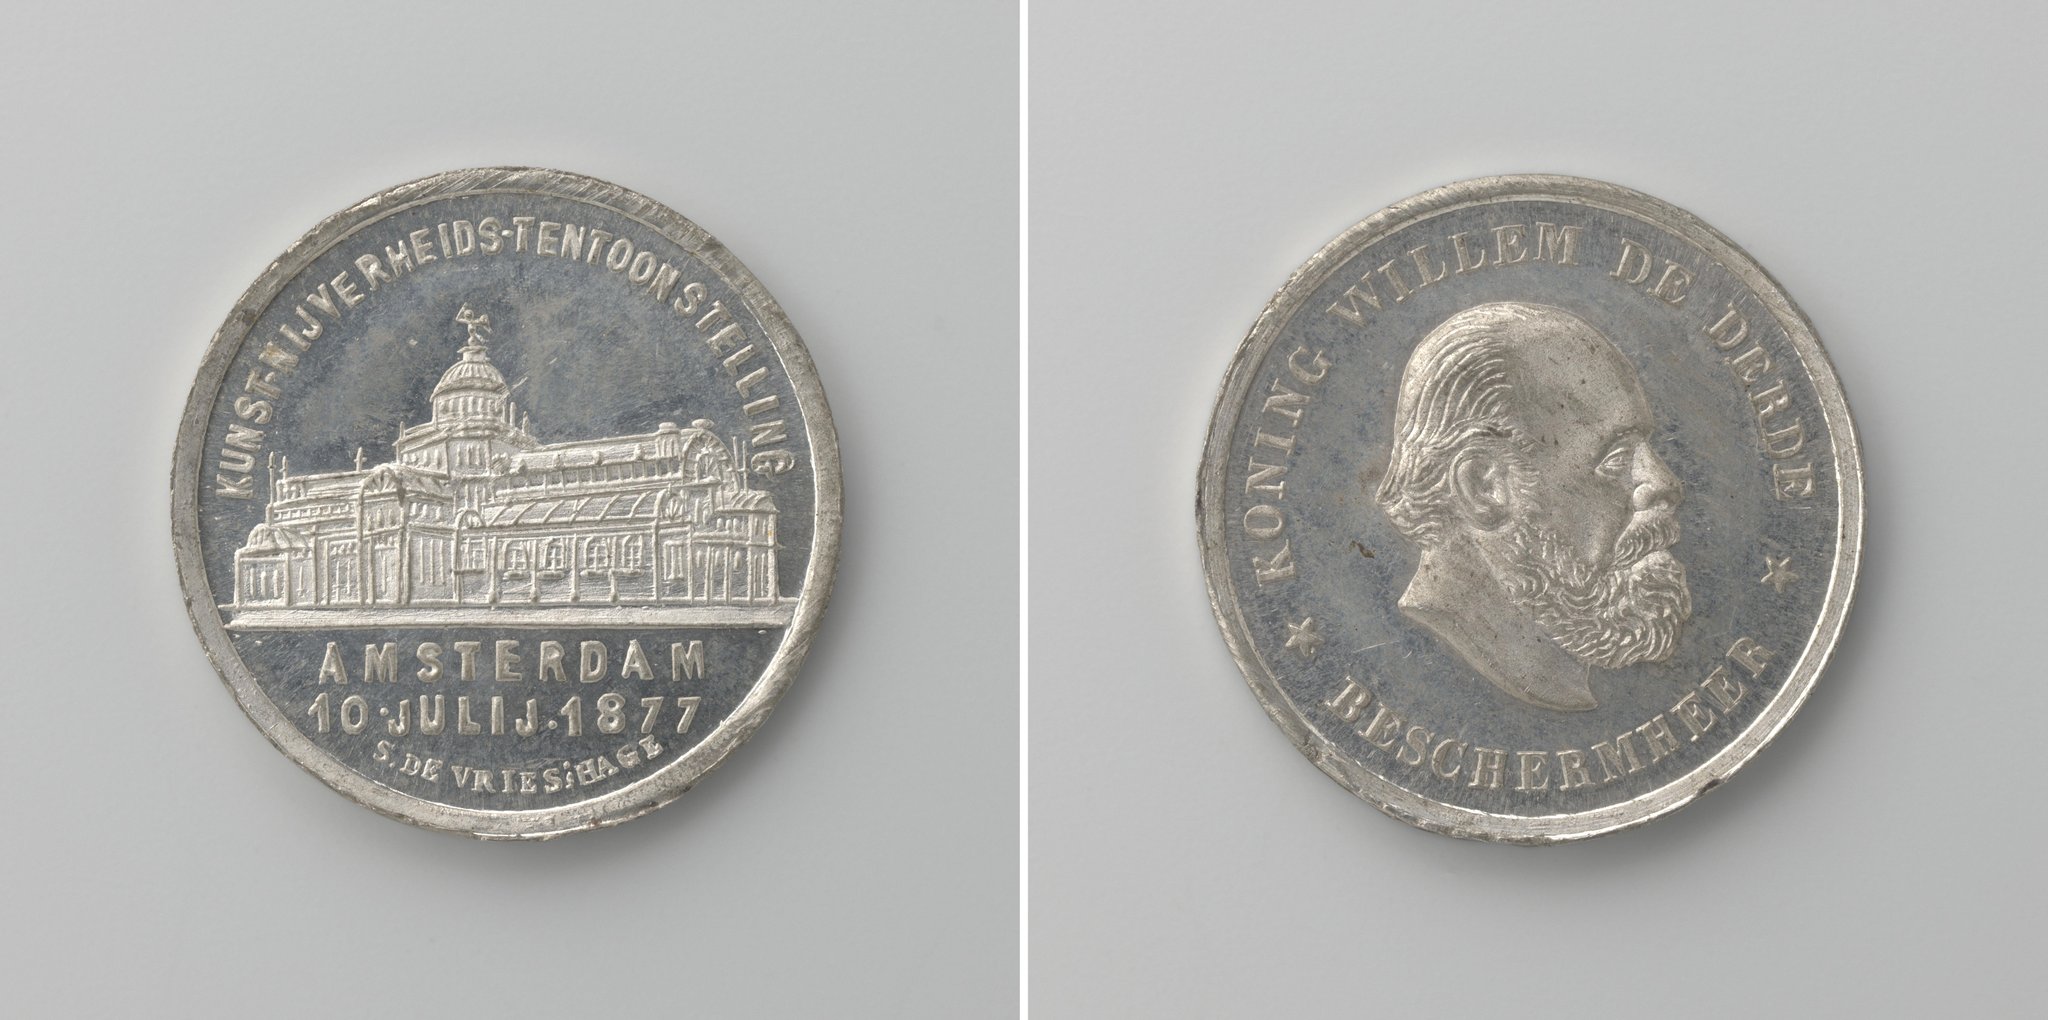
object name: history medal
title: Internationale tentoonstelling van kunstnijverheid te Amsterdam 1877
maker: salomon de vries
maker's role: graveur, medailleur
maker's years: 1830-1899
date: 1877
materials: tin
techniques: striking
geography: the hague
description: Tinnen penning, op de voorzijde het portret van Koning Willem III naar rechts met omschrift, op de keerzijde het aanzicht van het Paleis van Volksvlijt met omschrift en afsnedetekst.